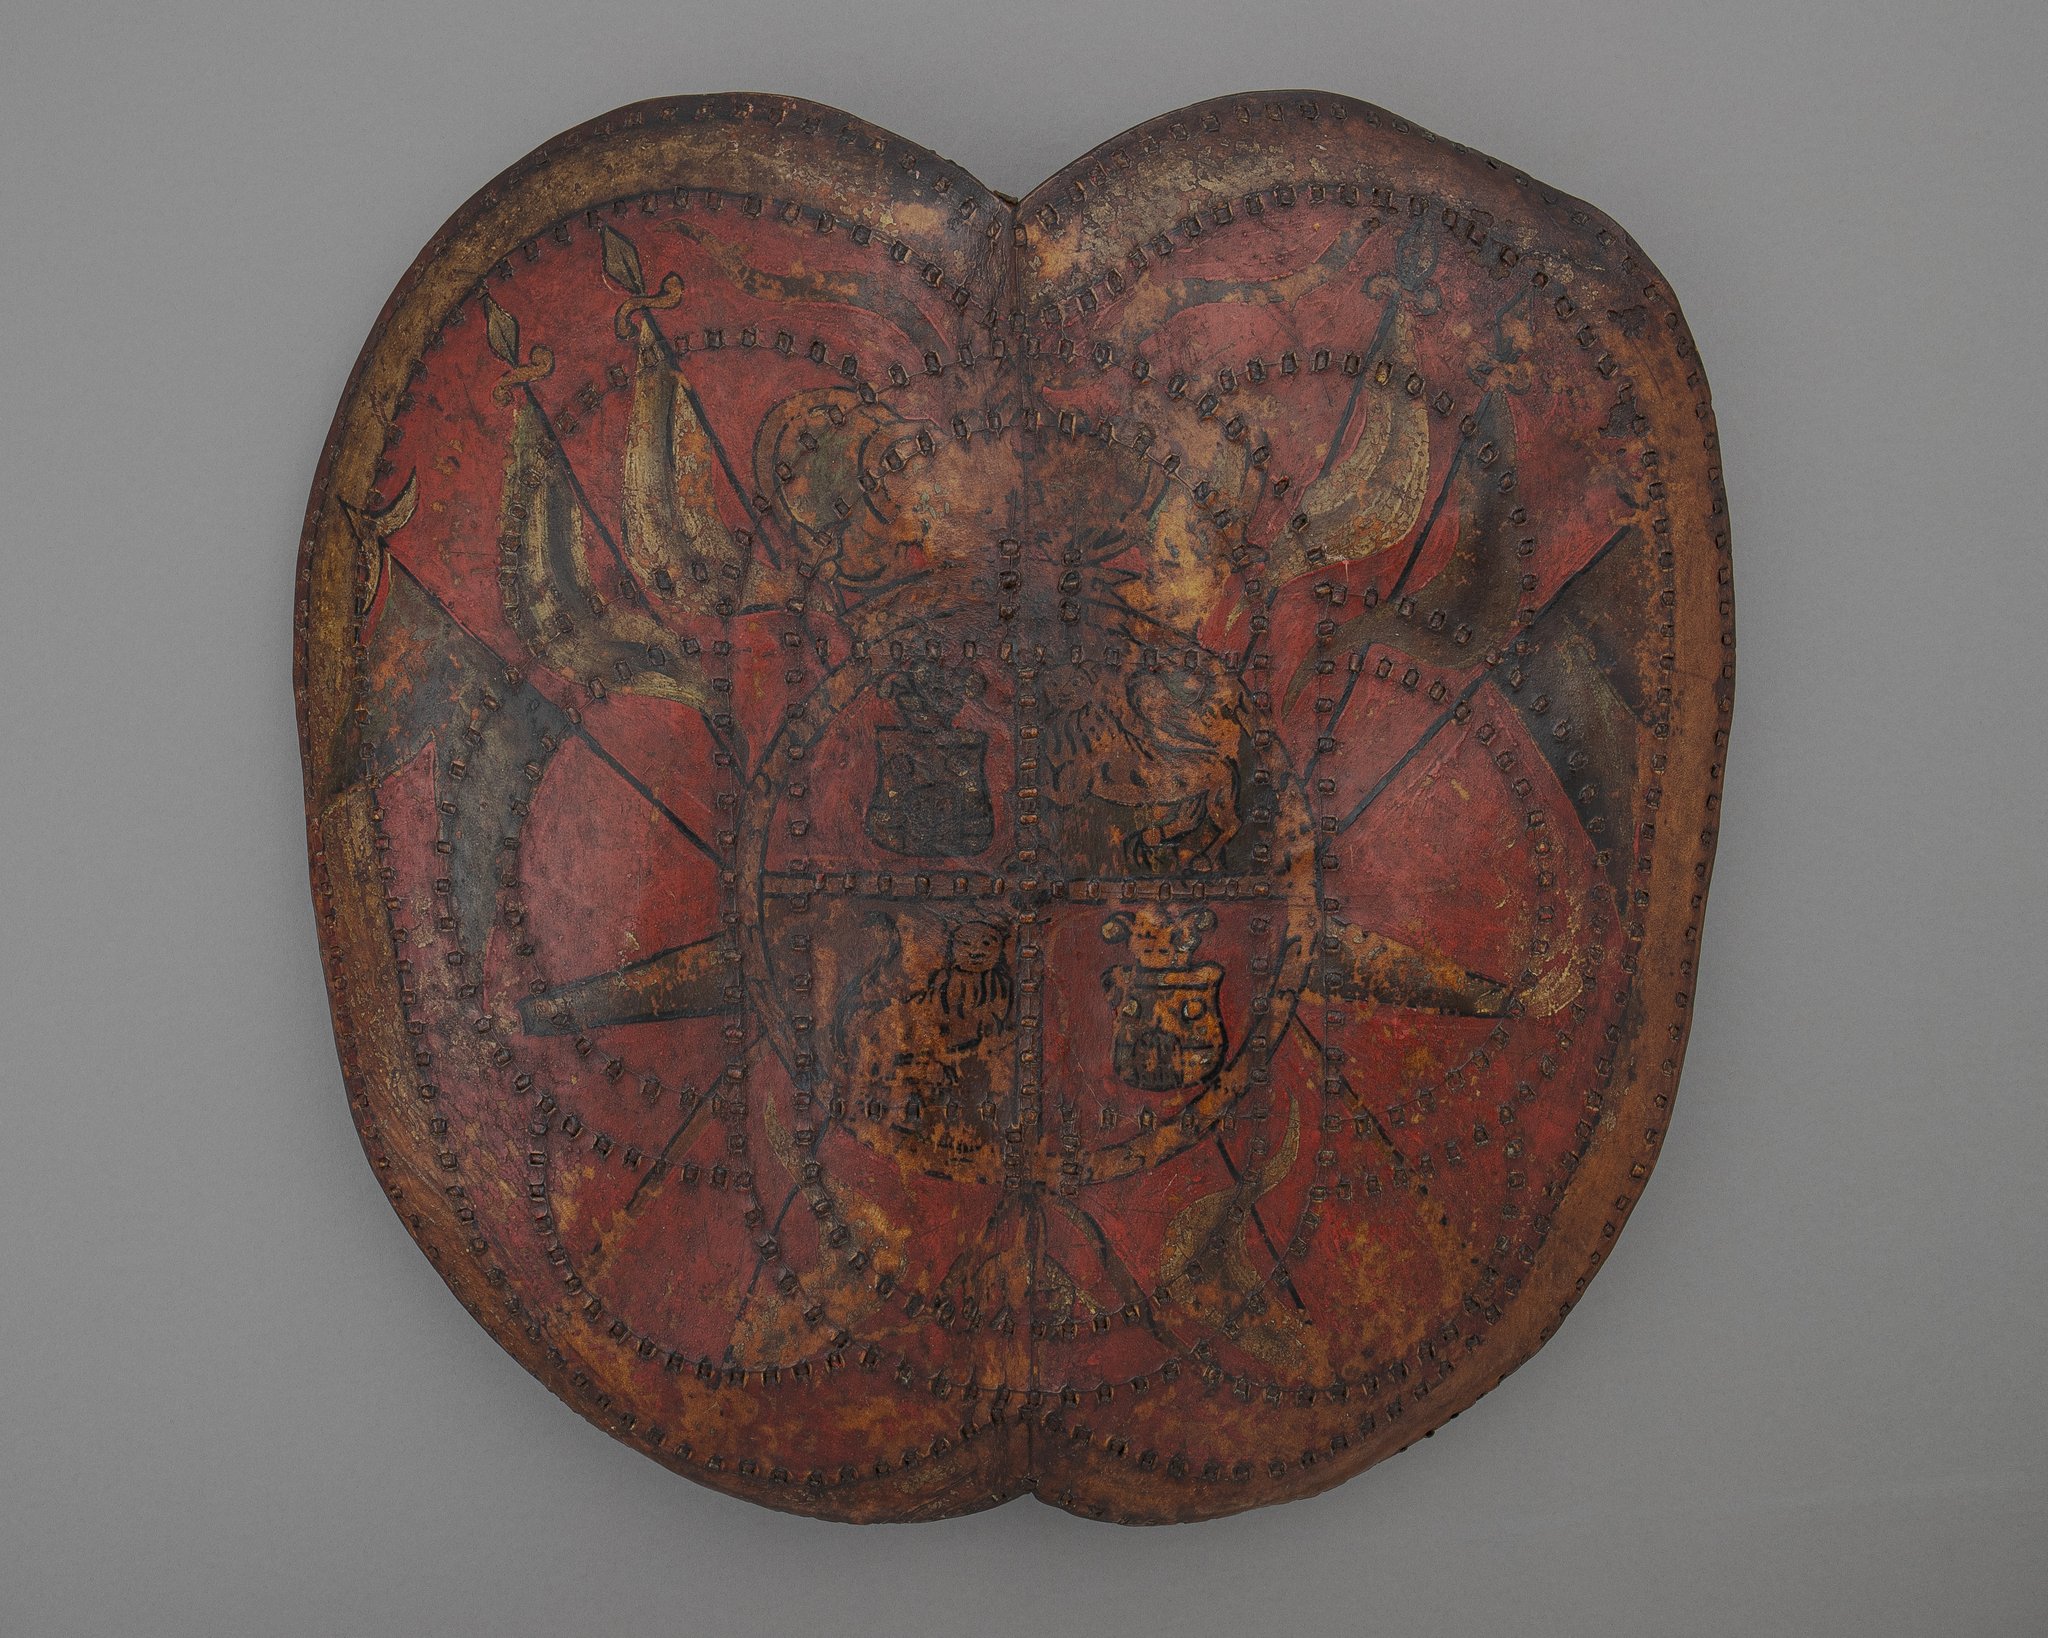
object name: shield i adarga i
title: Shield (Adarga)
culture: mexican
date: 1734-1766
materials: leather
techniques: polychromy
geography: mexico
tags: coat of arms